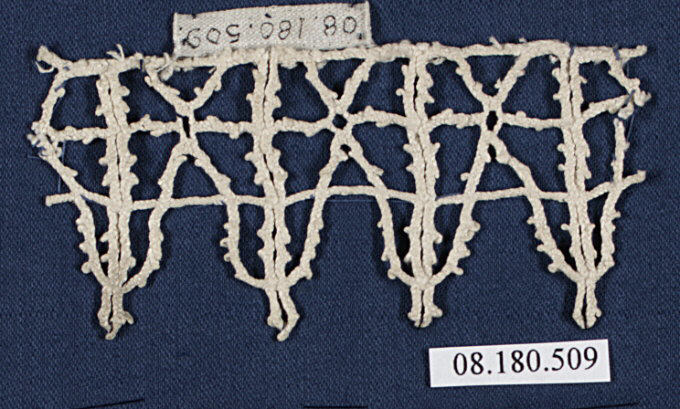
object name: fragment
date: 1501-1600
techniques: lace